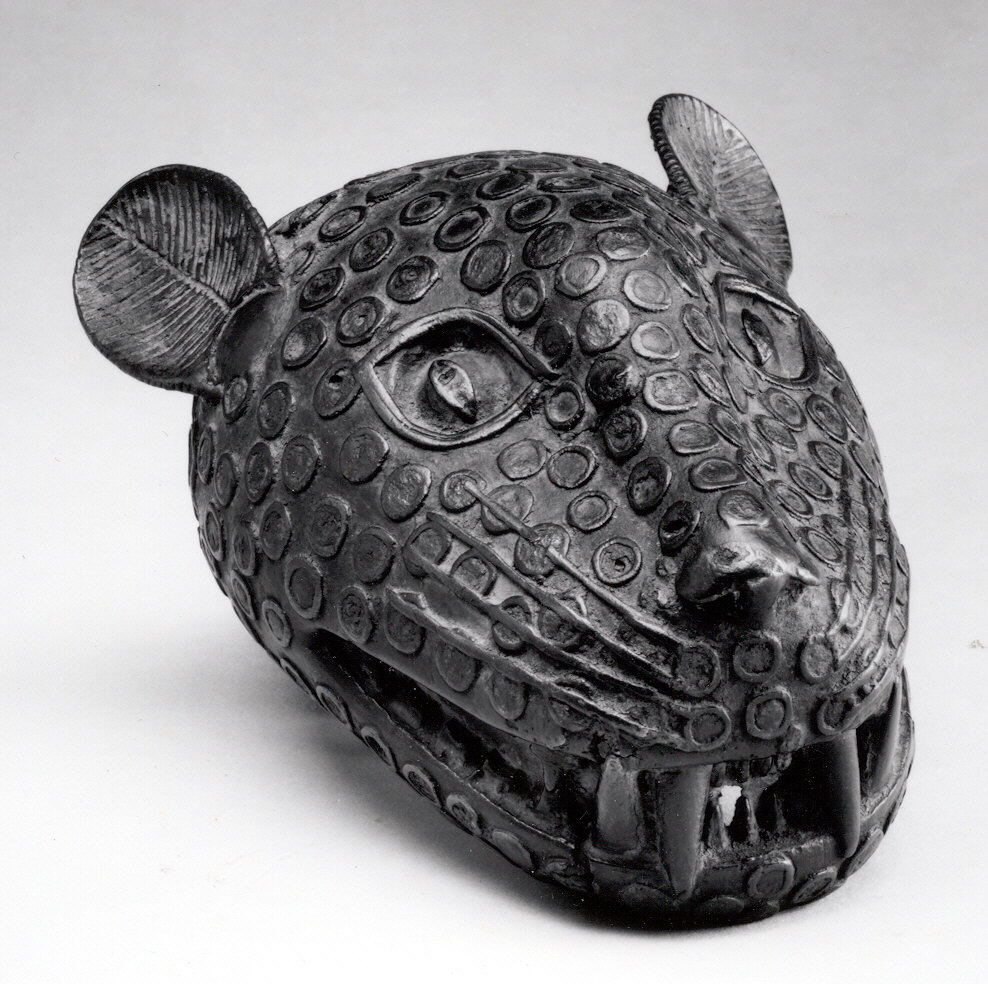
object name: head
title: Figure: Leopard Head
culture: edo period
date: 1501-1900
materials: brass, iron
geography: nigeria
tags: leopards